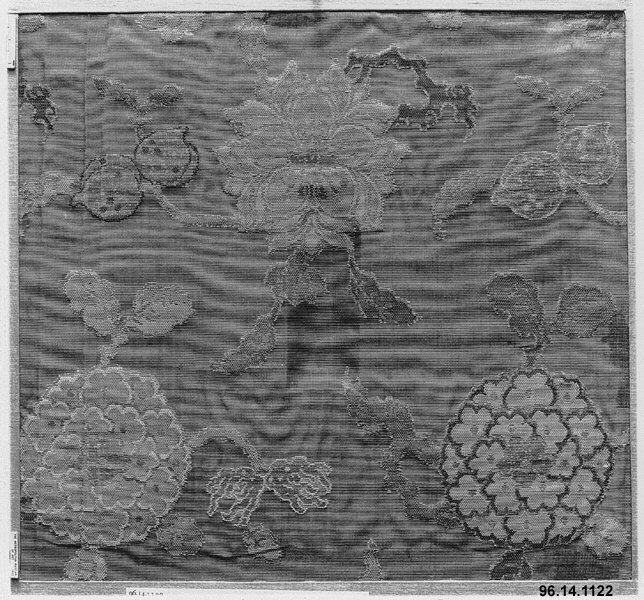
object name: piece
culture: japanese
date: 1701-1900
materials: silk